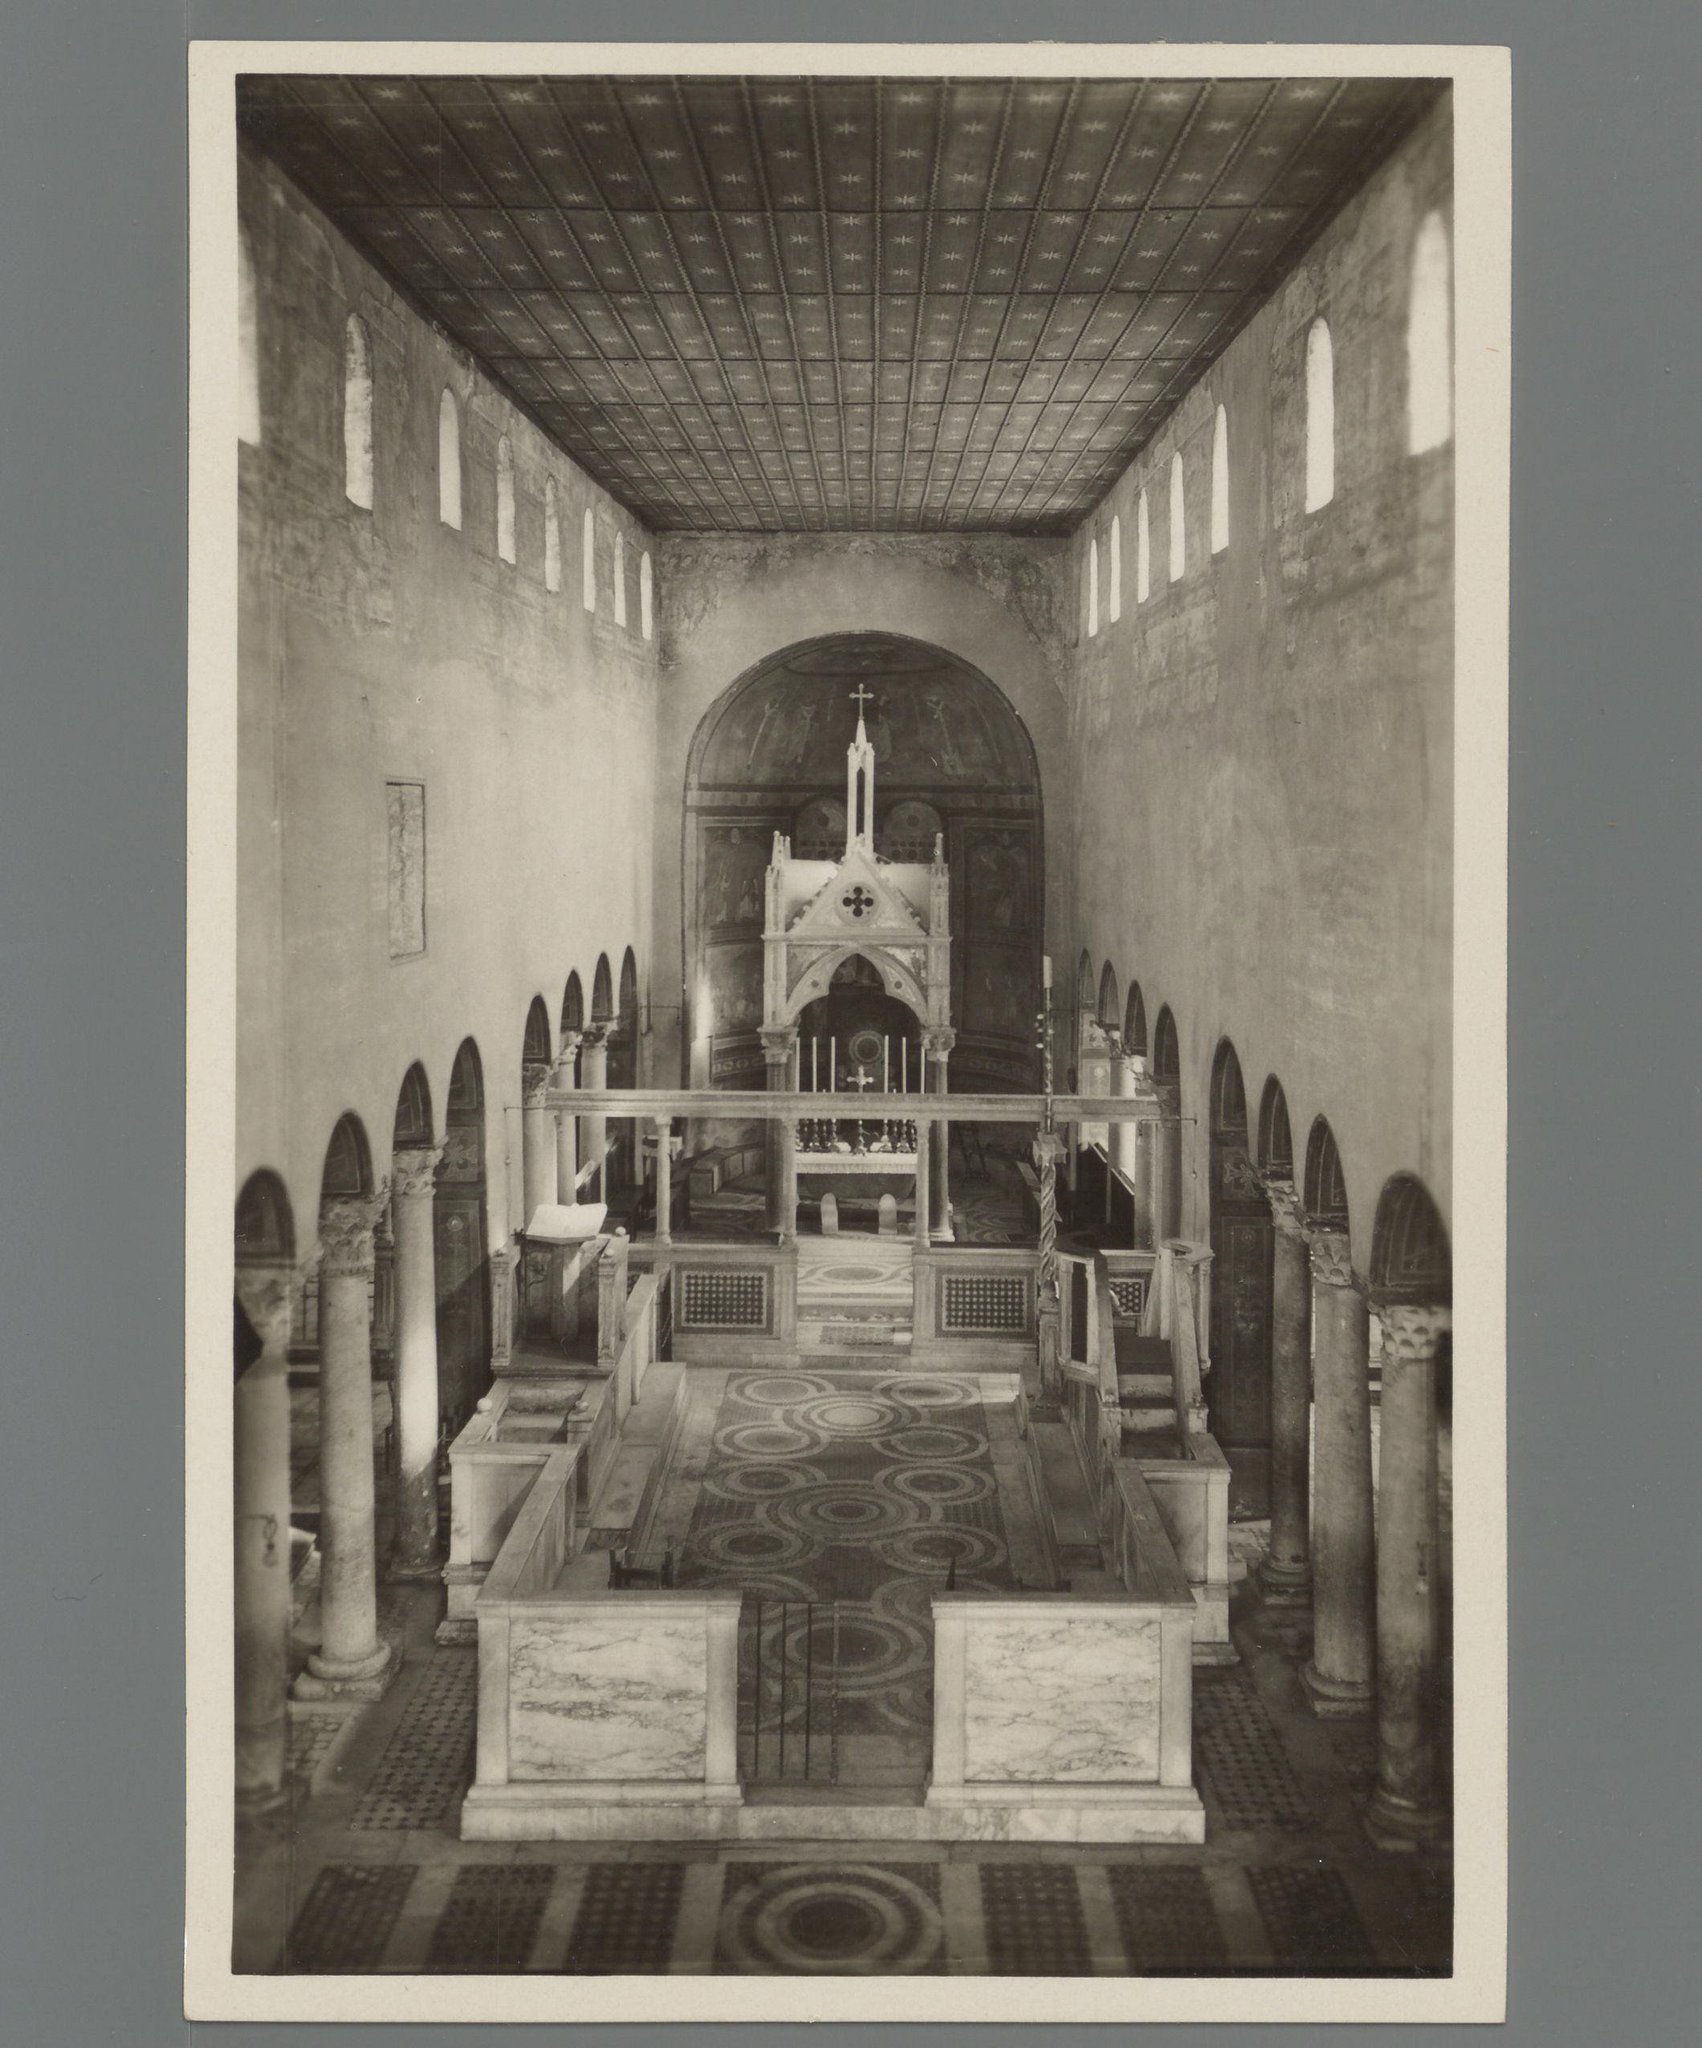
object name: ansichtkaart, prentbriefkaart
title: Roma. Interno della Chiesa di S. Maria in Cosmedin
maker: Anonymous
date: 1932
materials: photographic support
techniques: photography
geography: rome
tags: interior of church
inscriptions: date